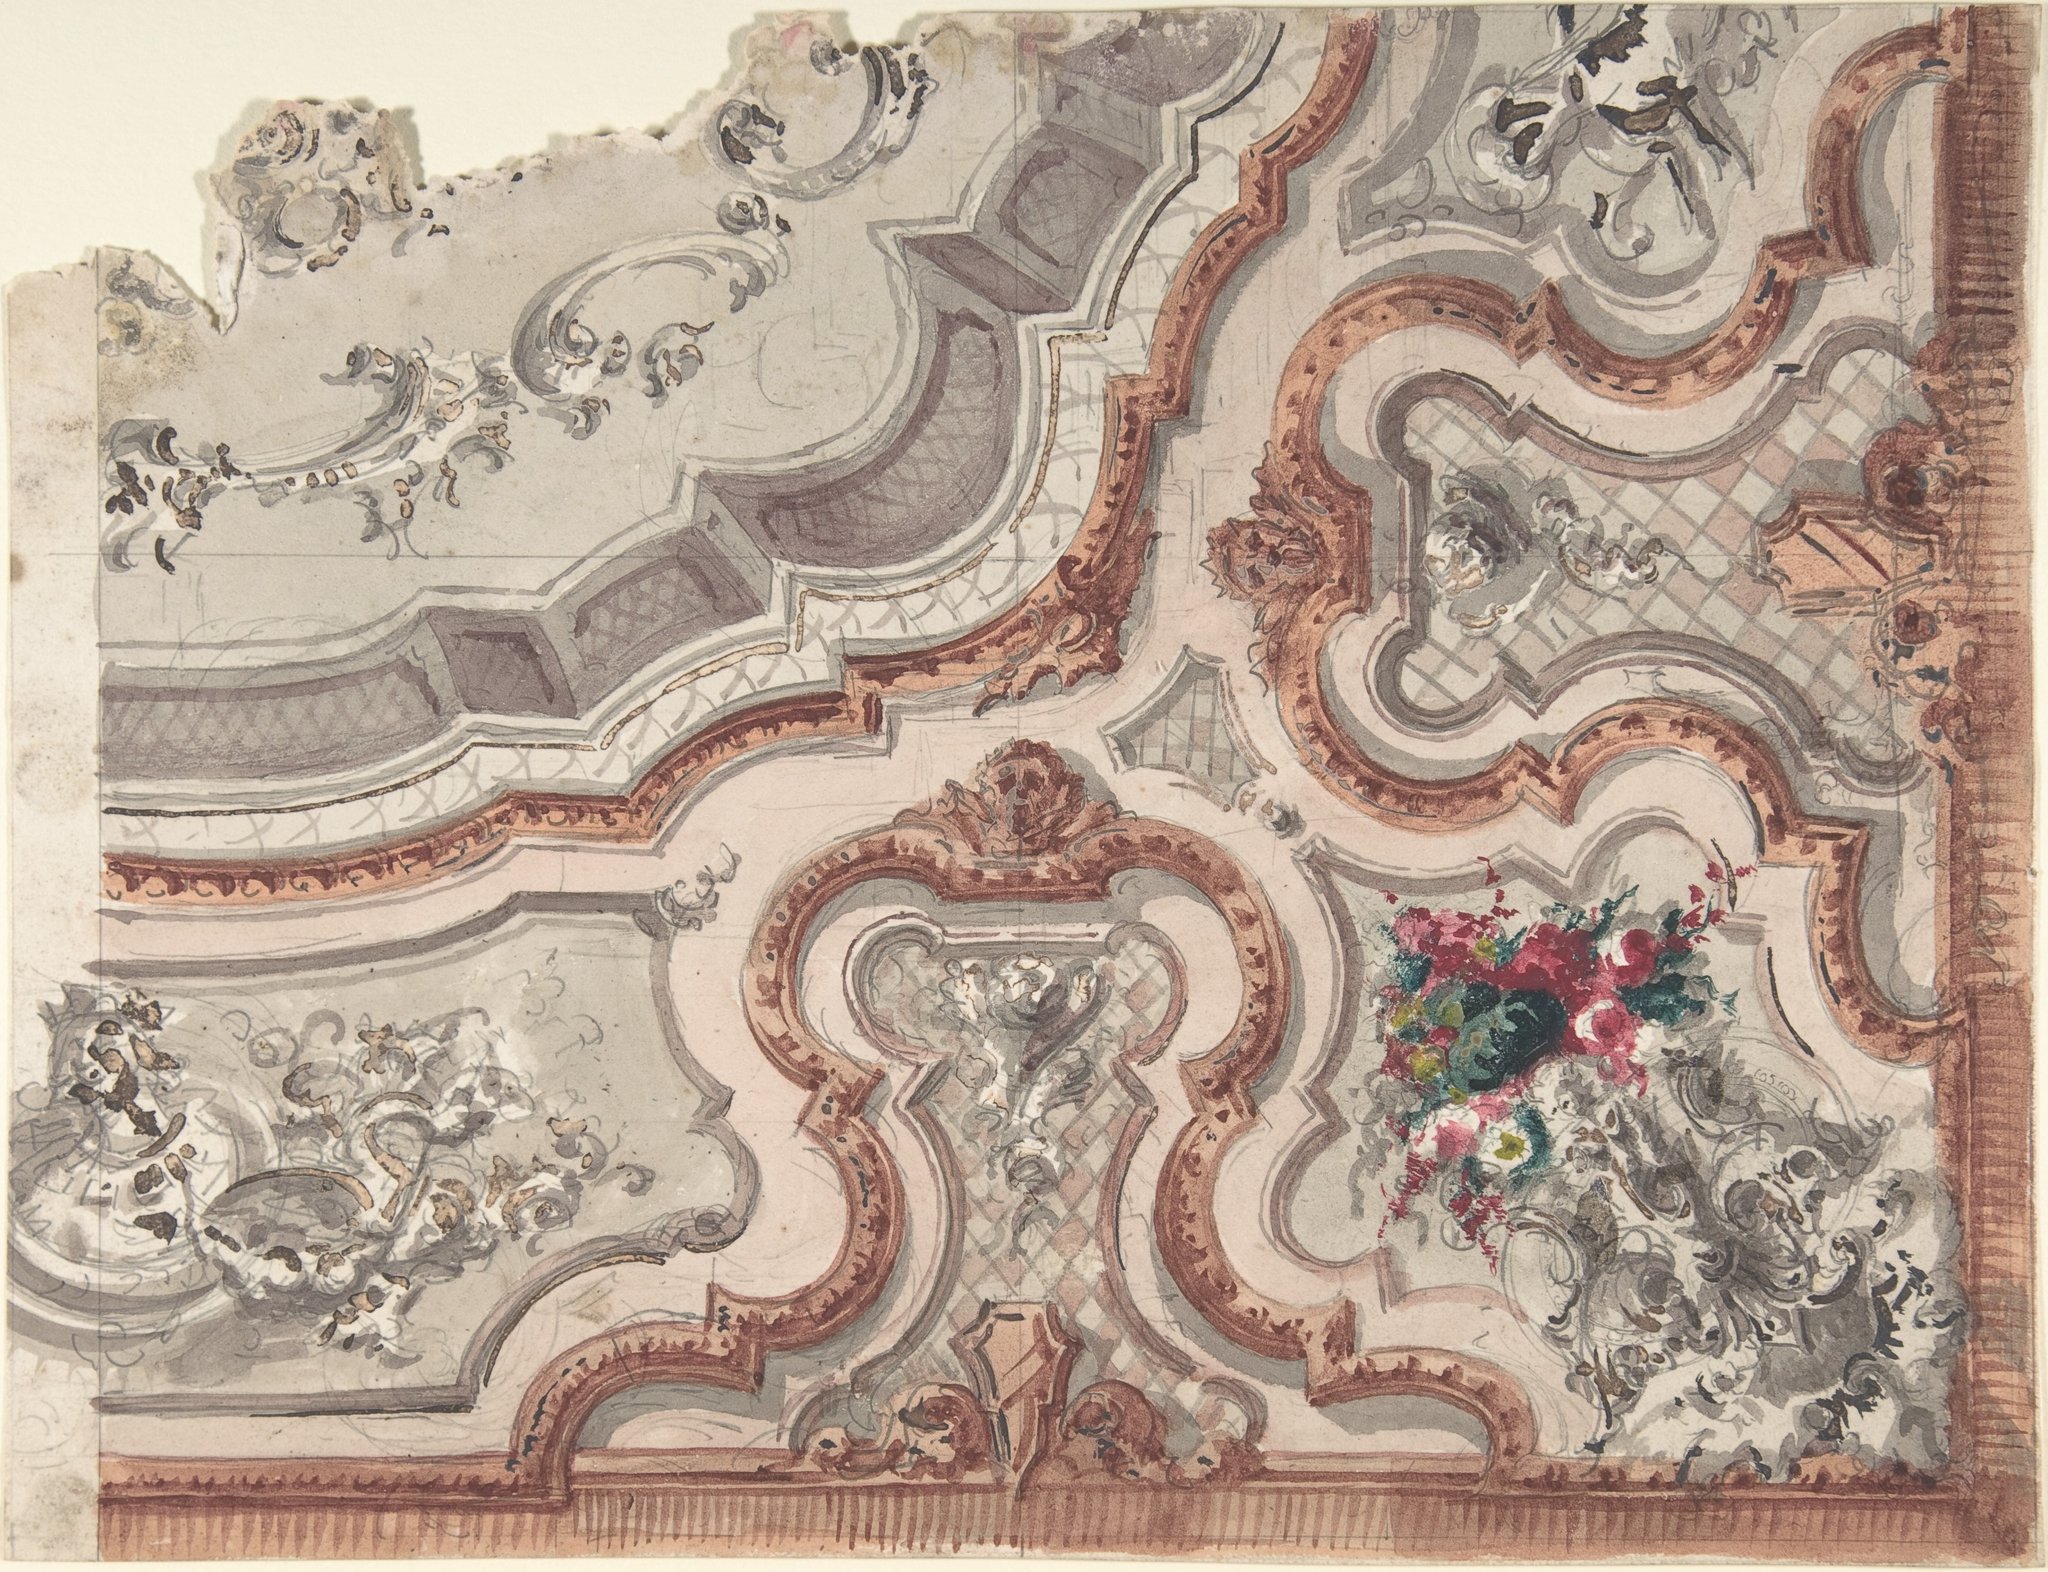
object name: drawing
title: Design for a Painted Ceiling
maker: anonymous, italian, 19th century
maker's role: artist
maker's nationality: italian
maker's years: 1800-1900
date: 1800-1900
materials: watercolor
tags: flowers